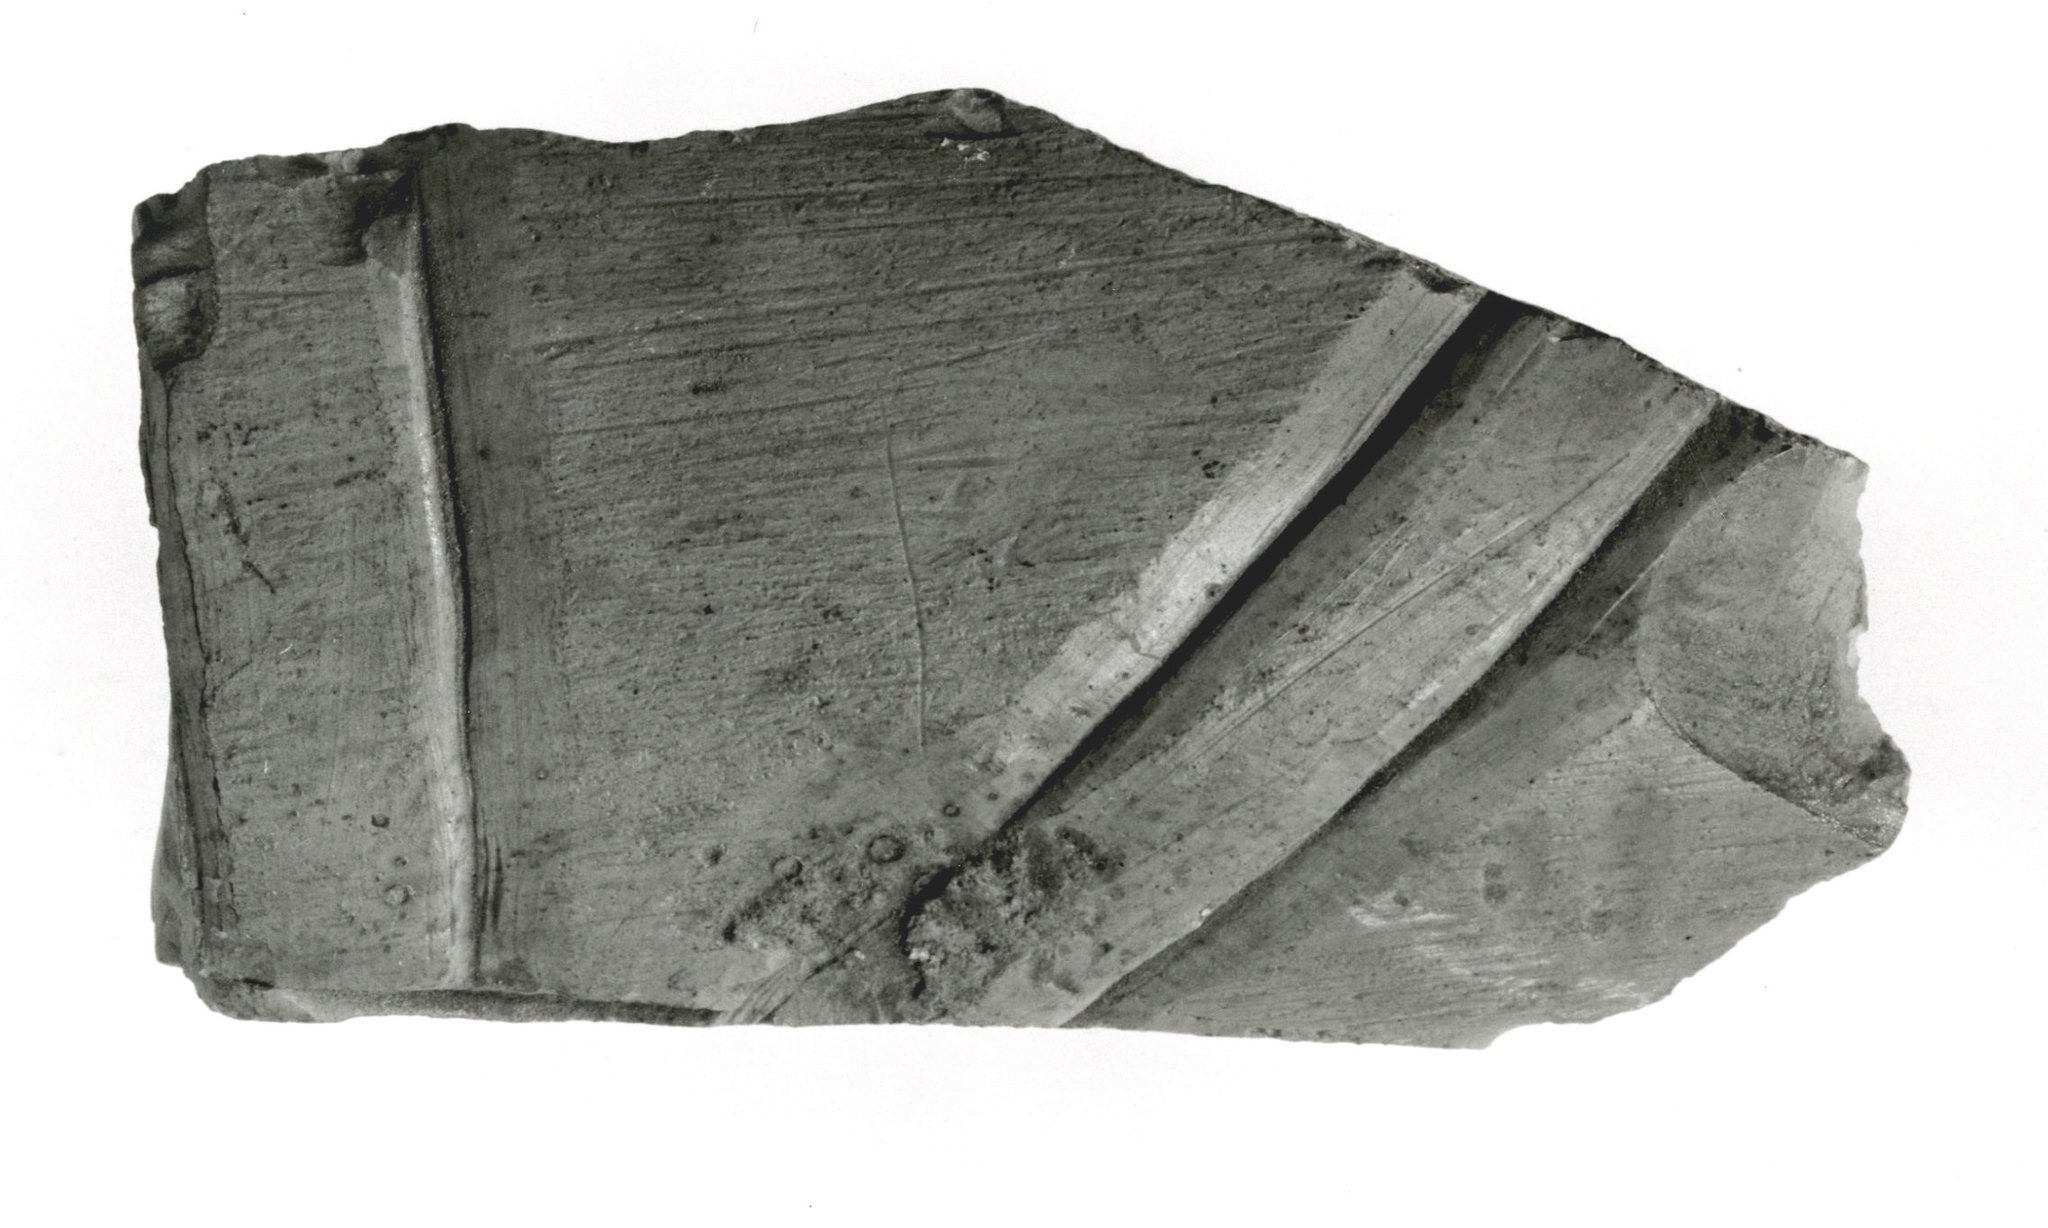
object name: relief, tomb of nespekashuty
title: Raised relief fragment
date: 664-610 BCE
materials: limestone, varnish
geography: egypt